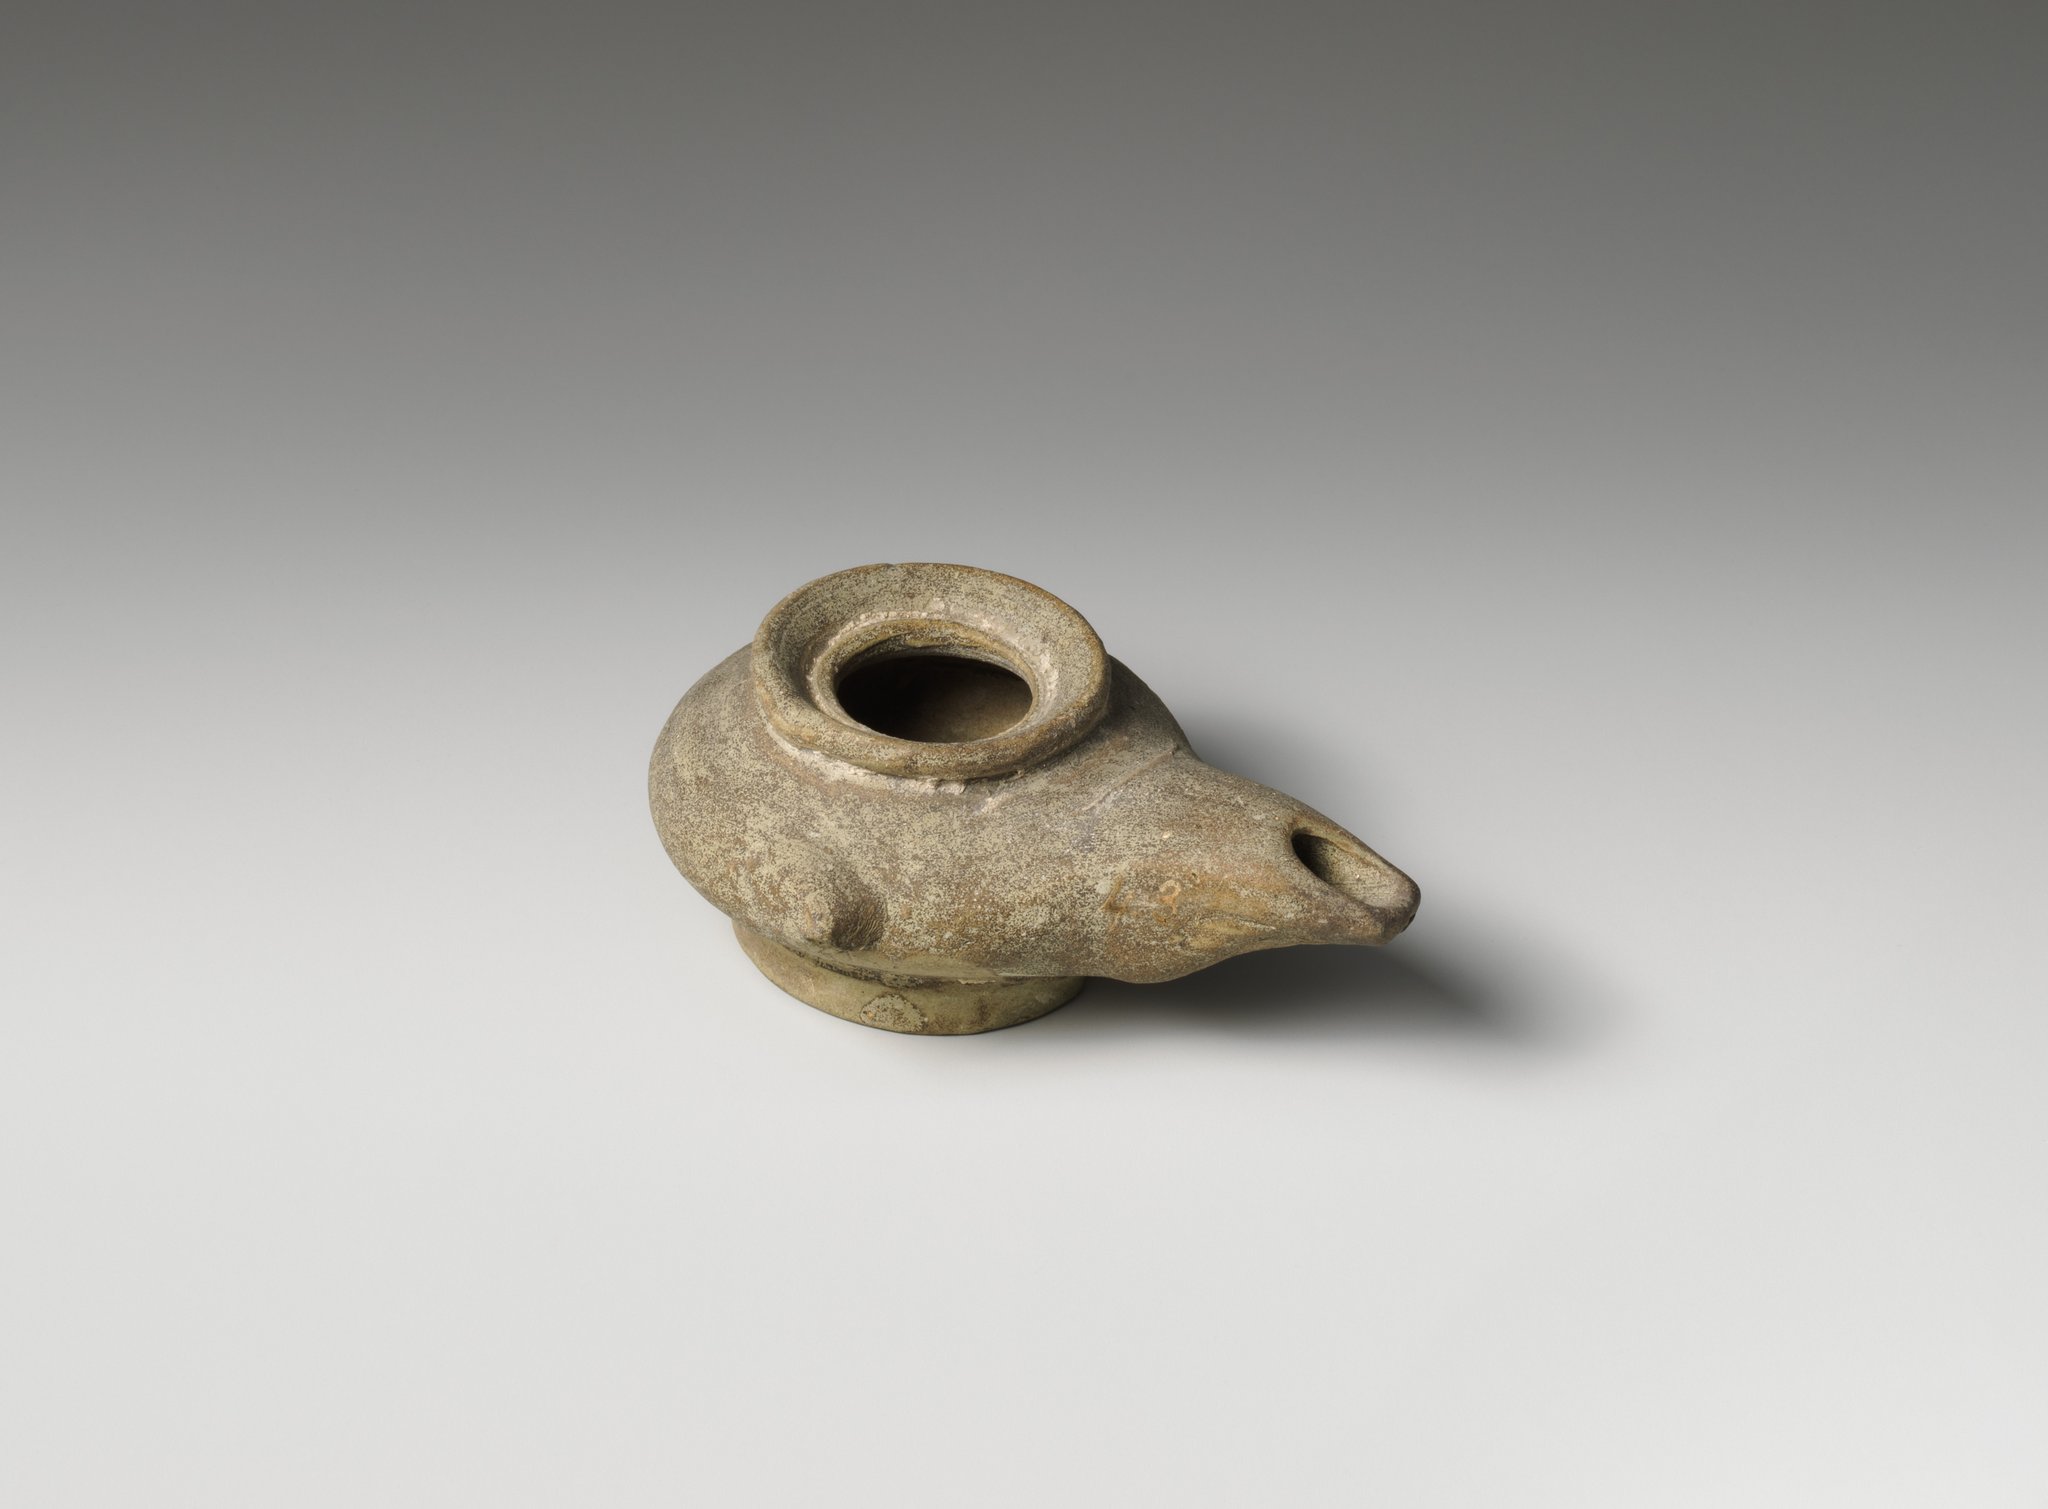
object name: lamp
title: Terracotta oil lamp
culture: greek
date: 200-101 BCE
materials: terracotta